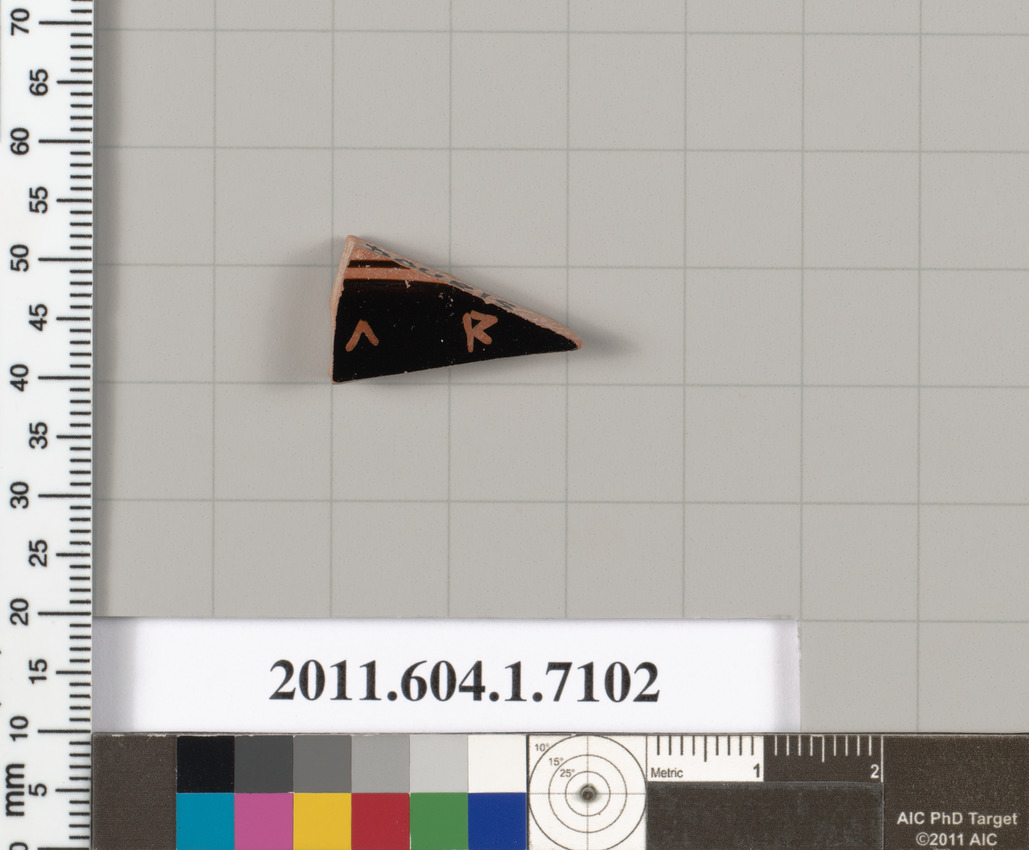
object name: kylix fragment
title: Terracotta fragment of a kylix (drinking cup)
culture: greek, attic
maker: douris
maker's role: artist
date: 500-480 BCE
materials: terracotta